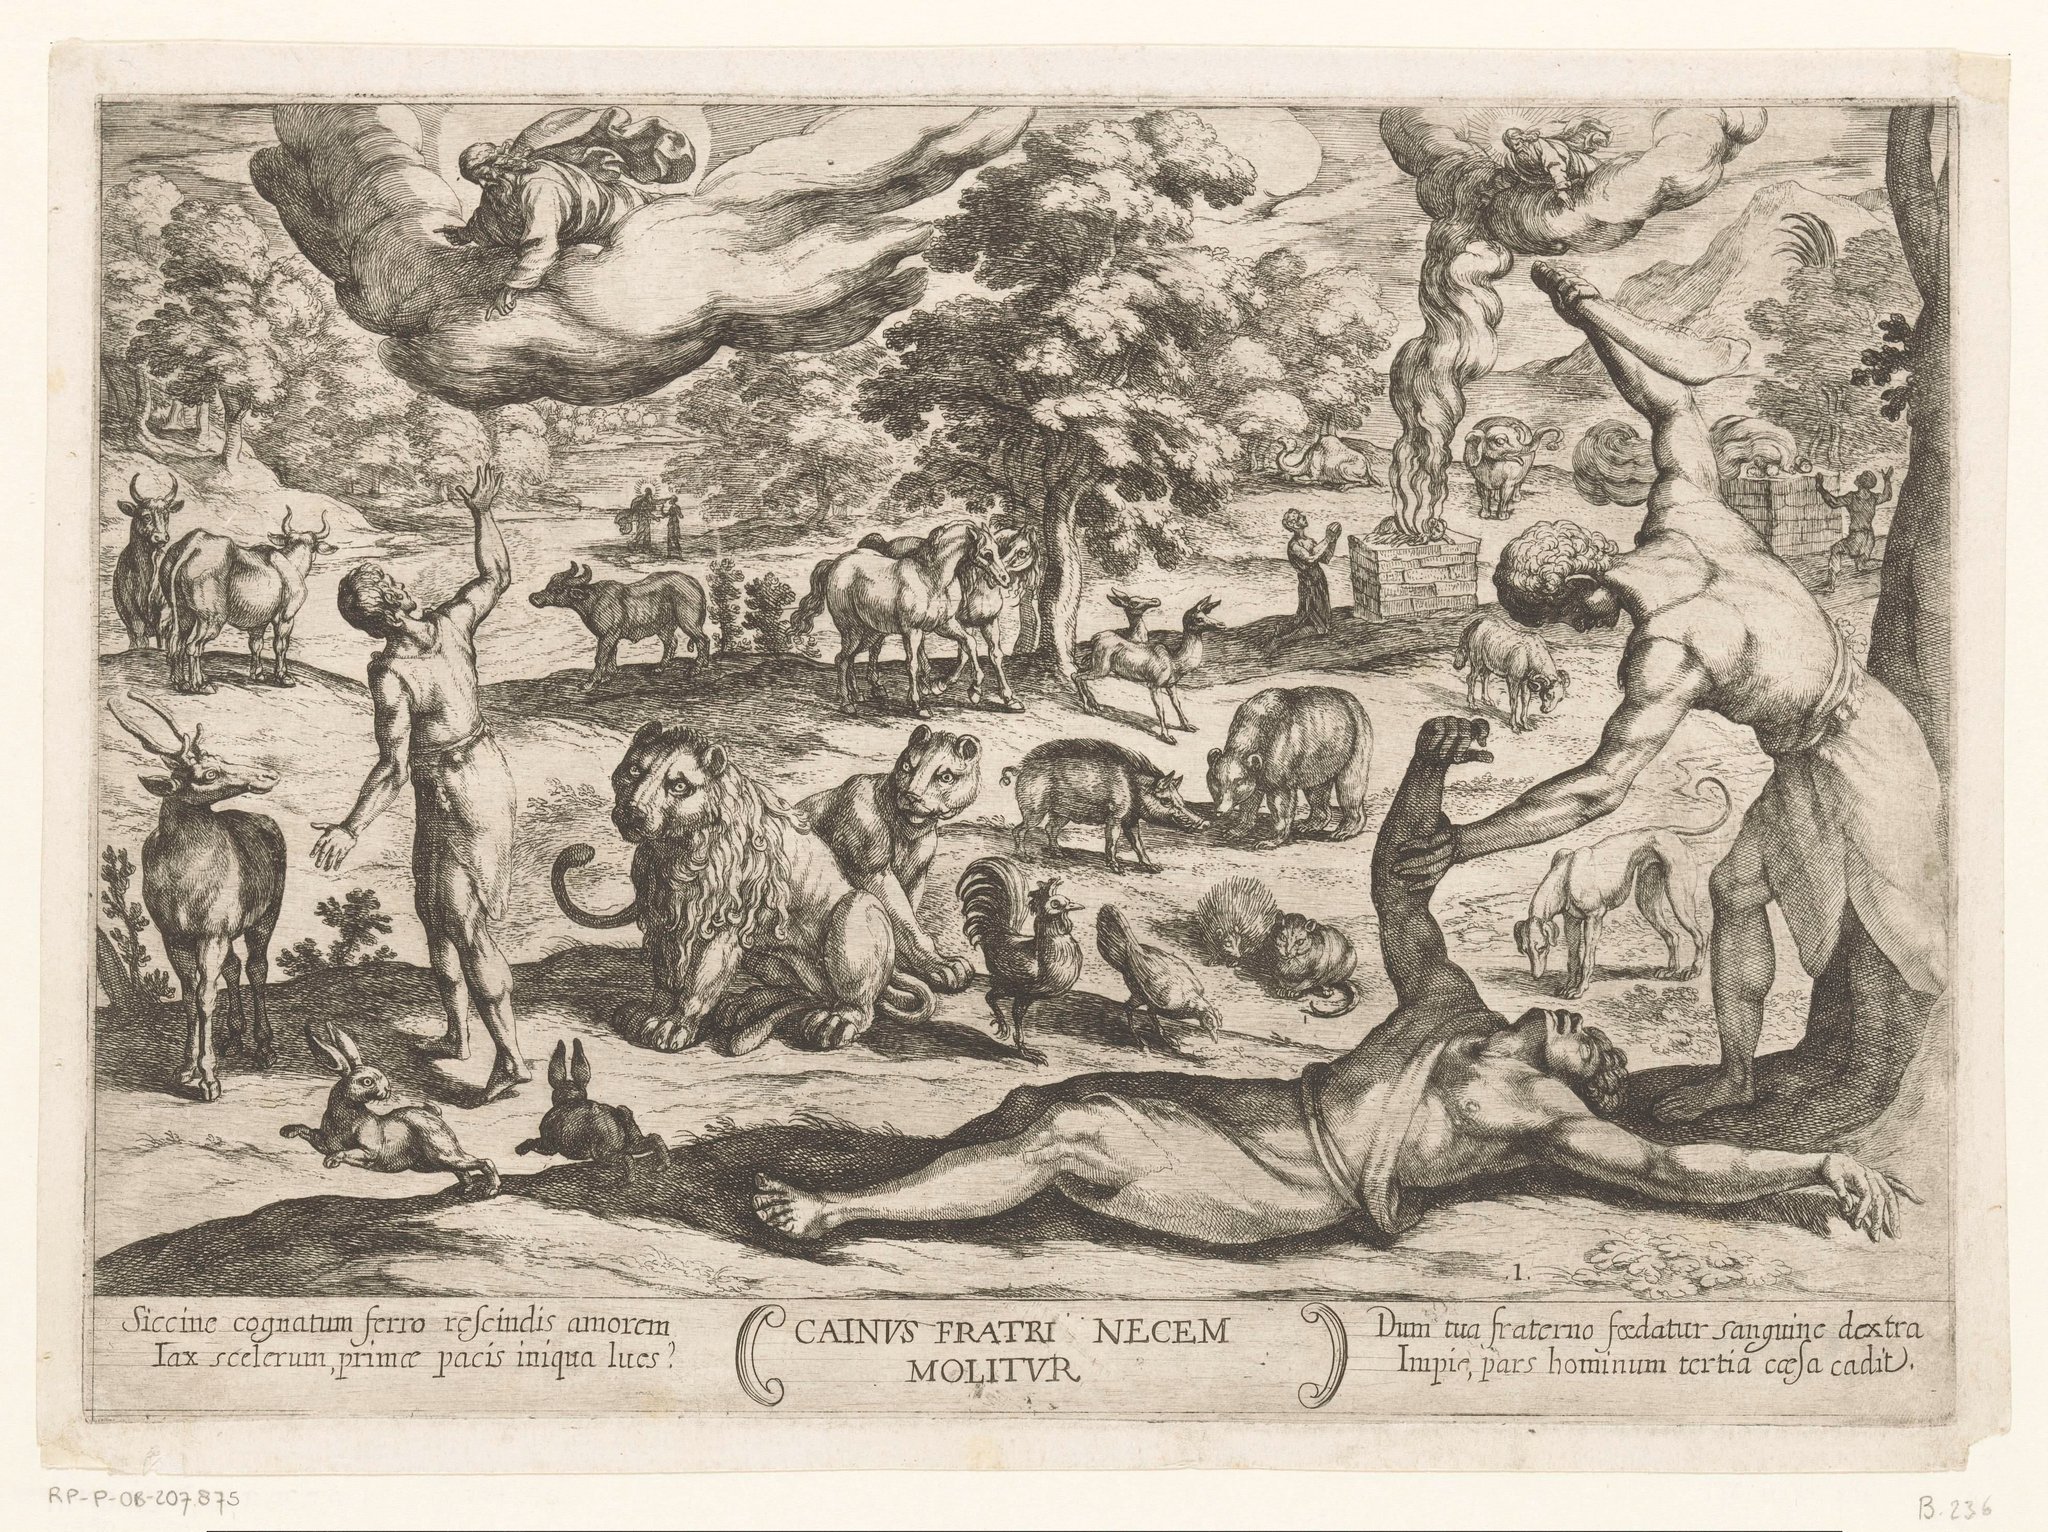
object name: print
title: Cainus fratri necem molitur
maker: antonio tempesta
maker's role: draughtsman, painter, print maker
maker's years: 1555-1630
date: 1613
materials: paper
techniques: etching, intaglio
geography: italy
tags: abel's death, god puts a mark on cain, the sacrifice of cain and abel: abel offers a lamb, cain usually a sheaf of corn, the curse of cain, the story of cain and abel (genesis 4:3-17)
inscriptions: collector's mark: Lugt 2228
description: Kaïn doodt zijn broer Abel met een kaakbeen van een ezel in een landschap vol wilde dieren. Op de achtergrond rechts brengen Kaïn en Abel allebei een offer aan God. Op de voorgrond links wordt Kaïn verbannen door God. Op de achtergrond links ontvangt Kaïn zijn merk. Titel en onderschrift in het Latijn in de ondermarge. Genummerd rechtsonder: 1.